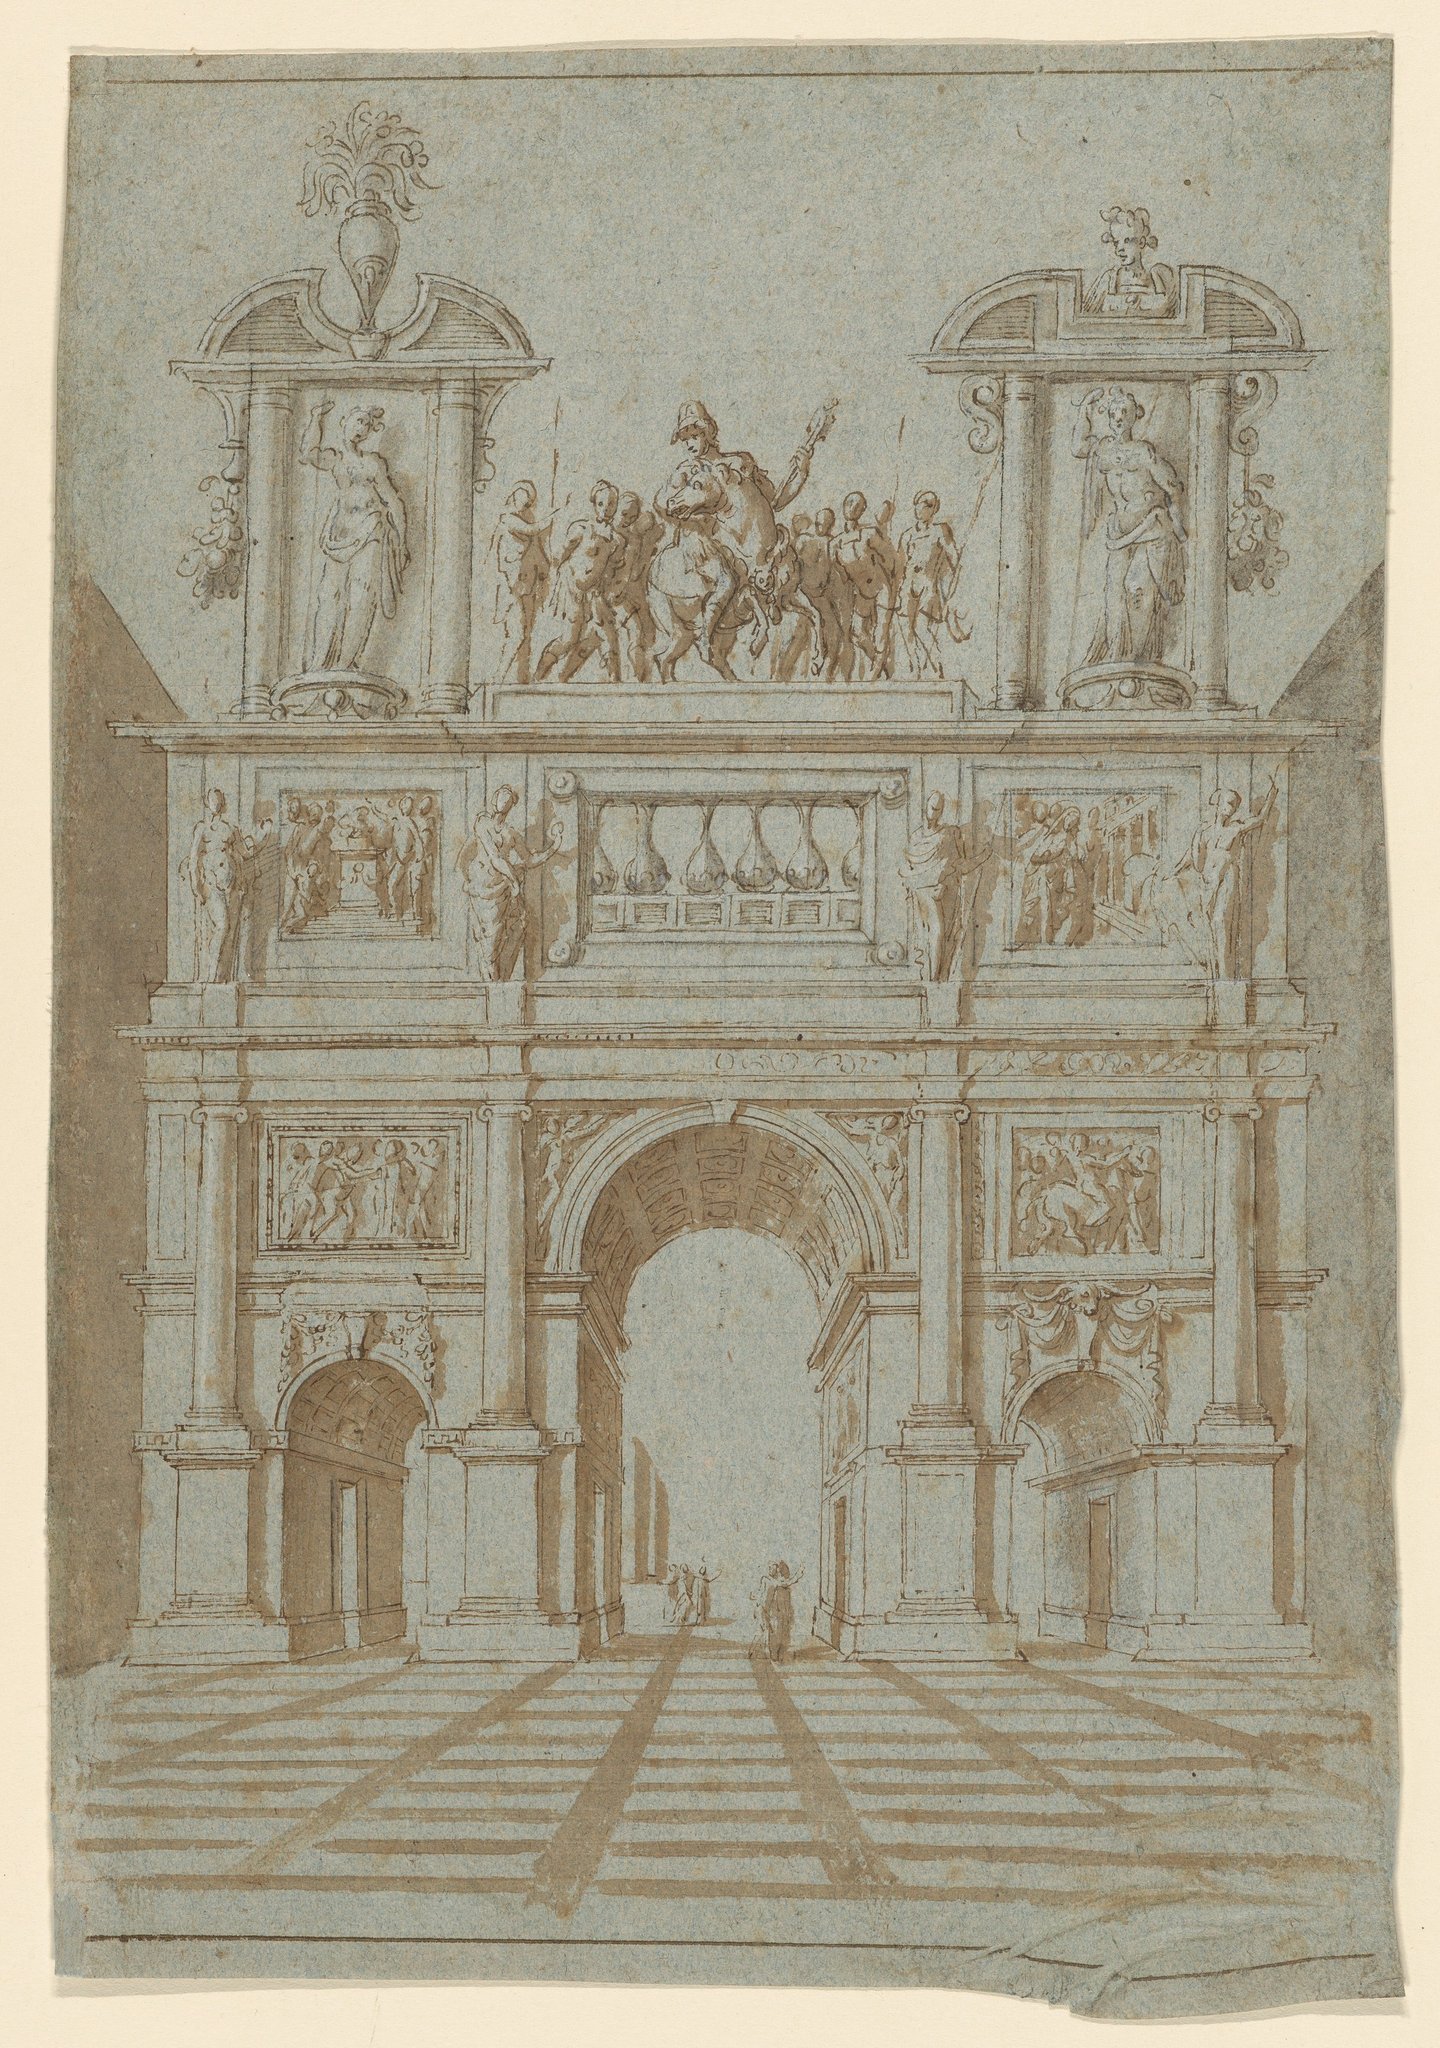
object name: drawing ornament architecture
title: Design for a Triumphal Arch in Perspectival Rendering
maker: anonymous, british, 17th century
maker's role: artist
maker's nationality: british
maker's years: 1600-1700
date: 1600-1630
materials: ink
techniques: brush, pen, wash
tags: architecture,arches